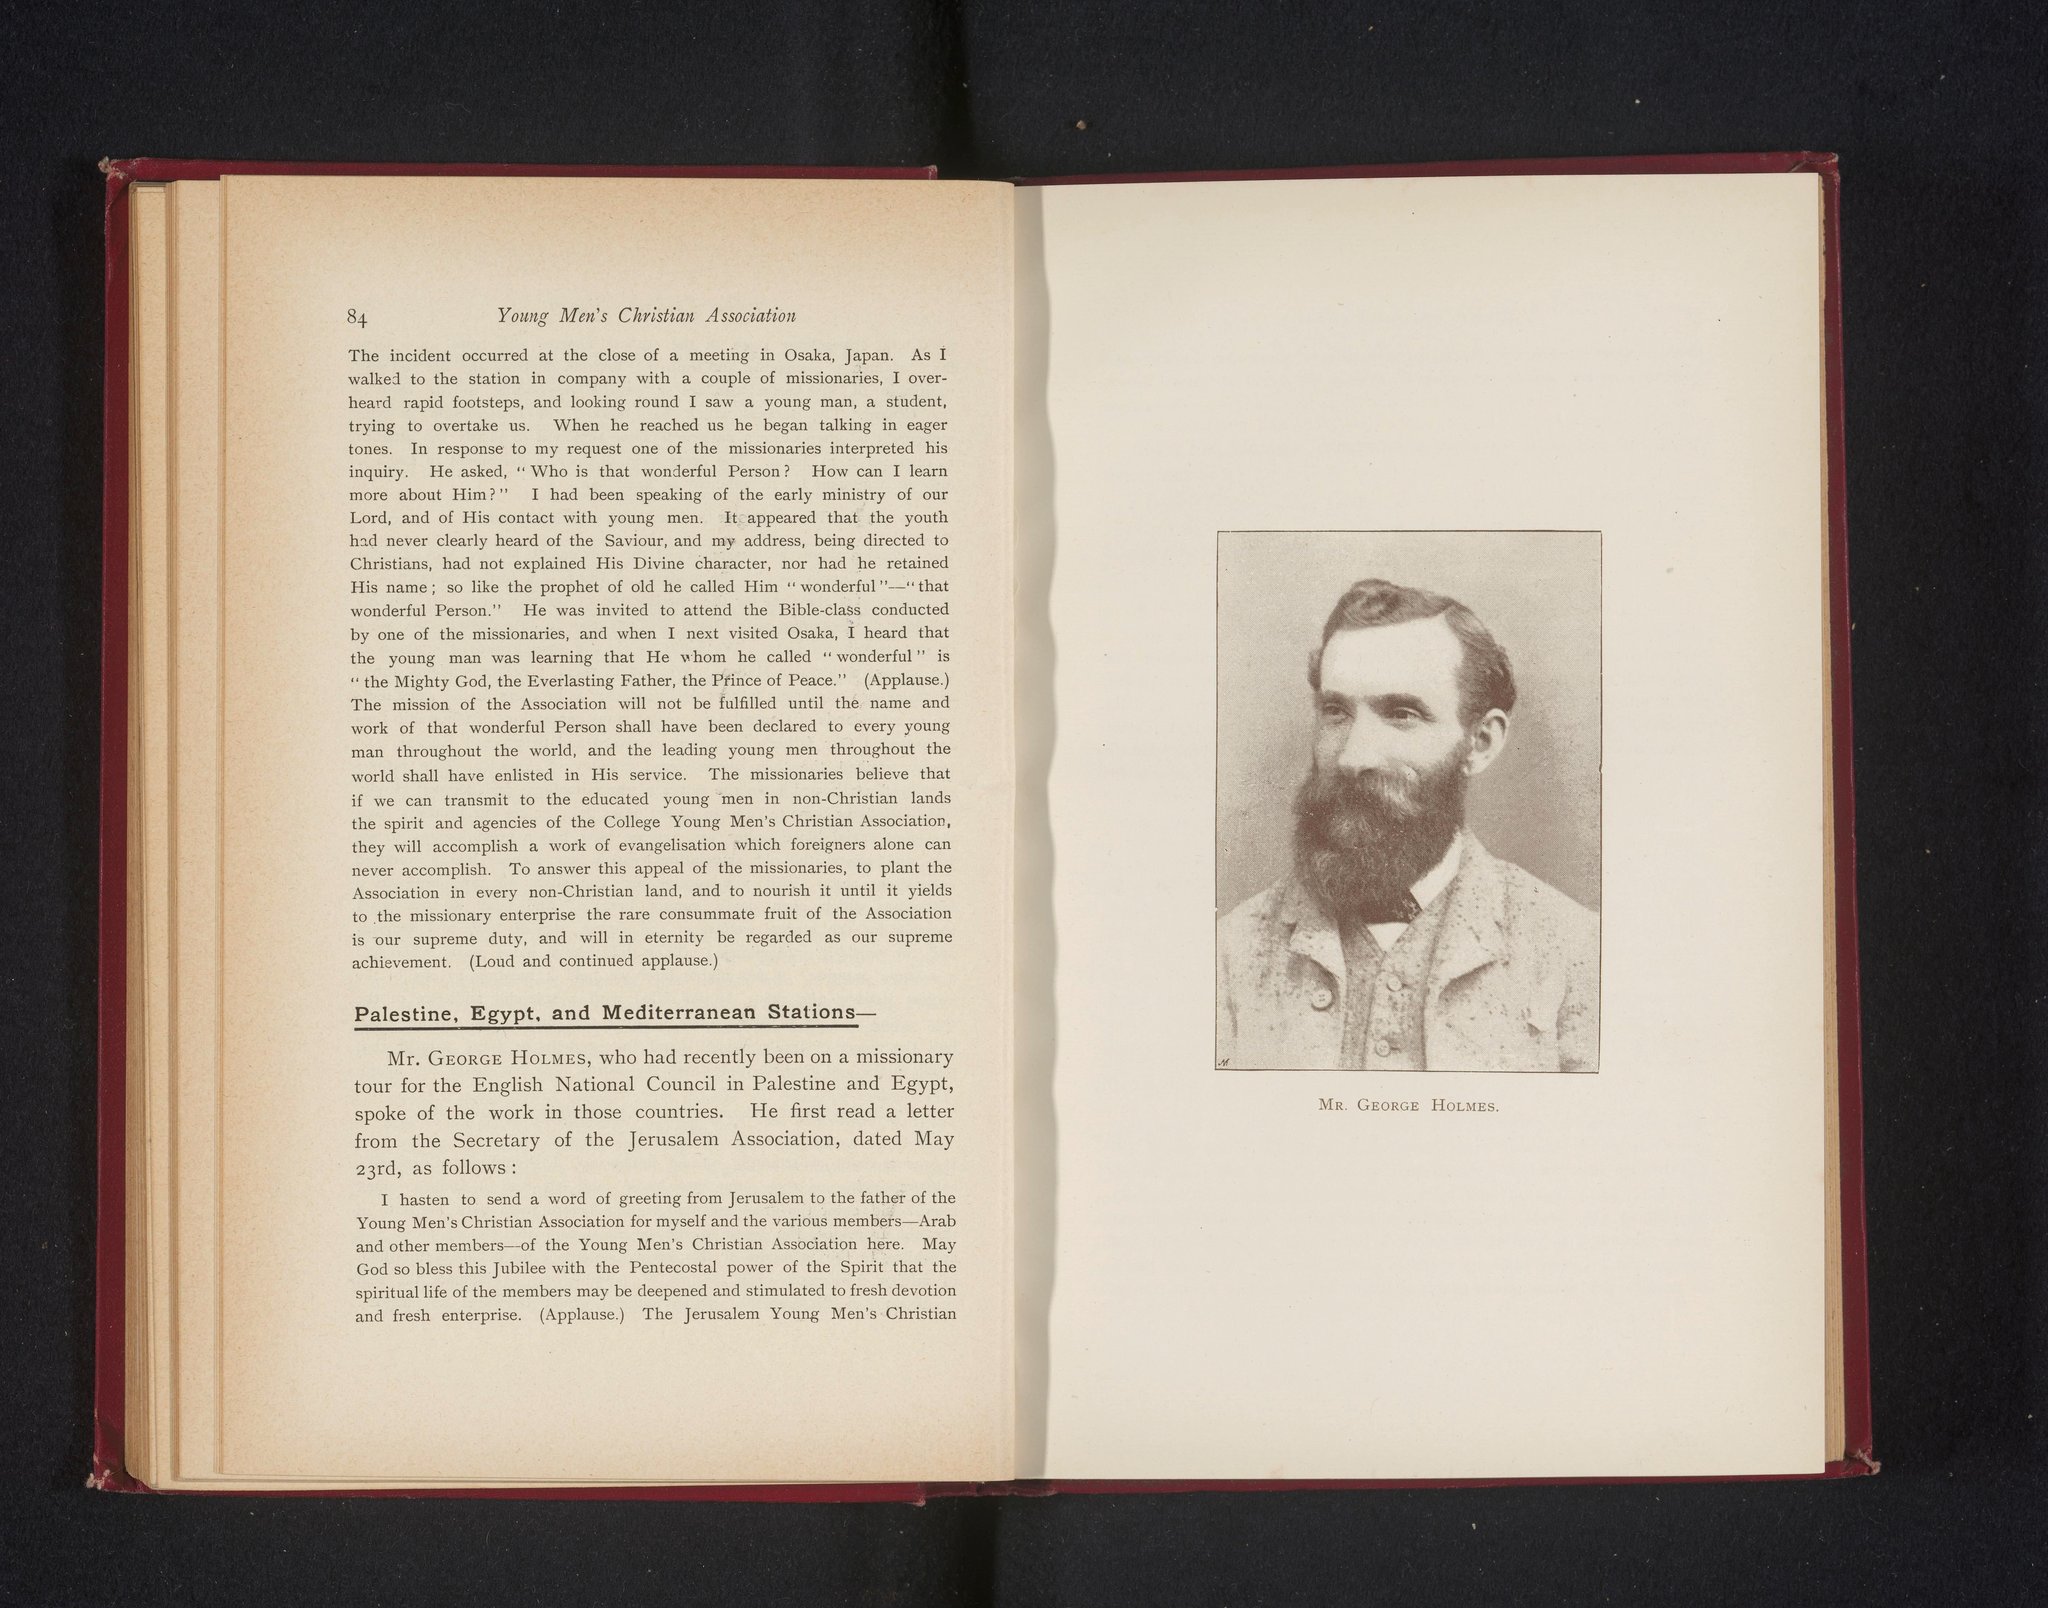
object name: page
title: Portret van George Holmes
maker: Anonymous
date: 1890-1895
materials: paper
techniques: autotype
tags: historical persons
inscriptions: monogram: ‘M’